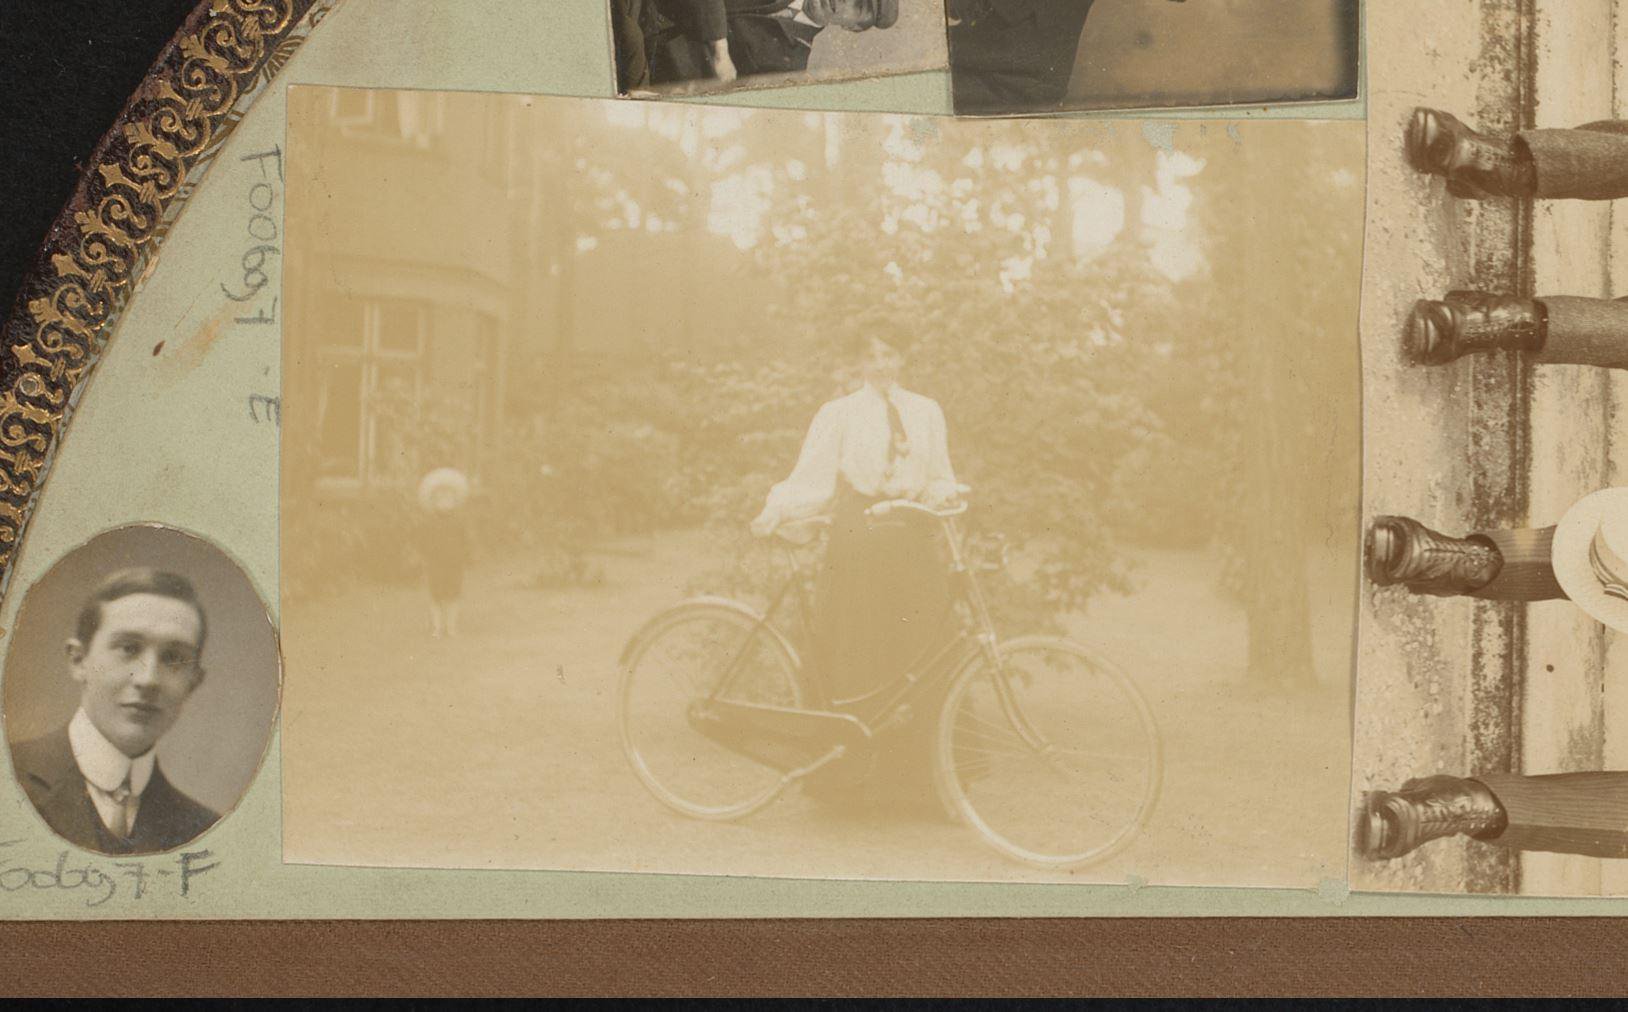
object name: photograph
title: Portret van een vrouw met een fiets in een tuin met een kind op achtergrond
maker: Anonymous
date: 1900-1915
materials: photographic support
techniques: gelatin silver print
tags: adult woman, child, historical persons, bicycle